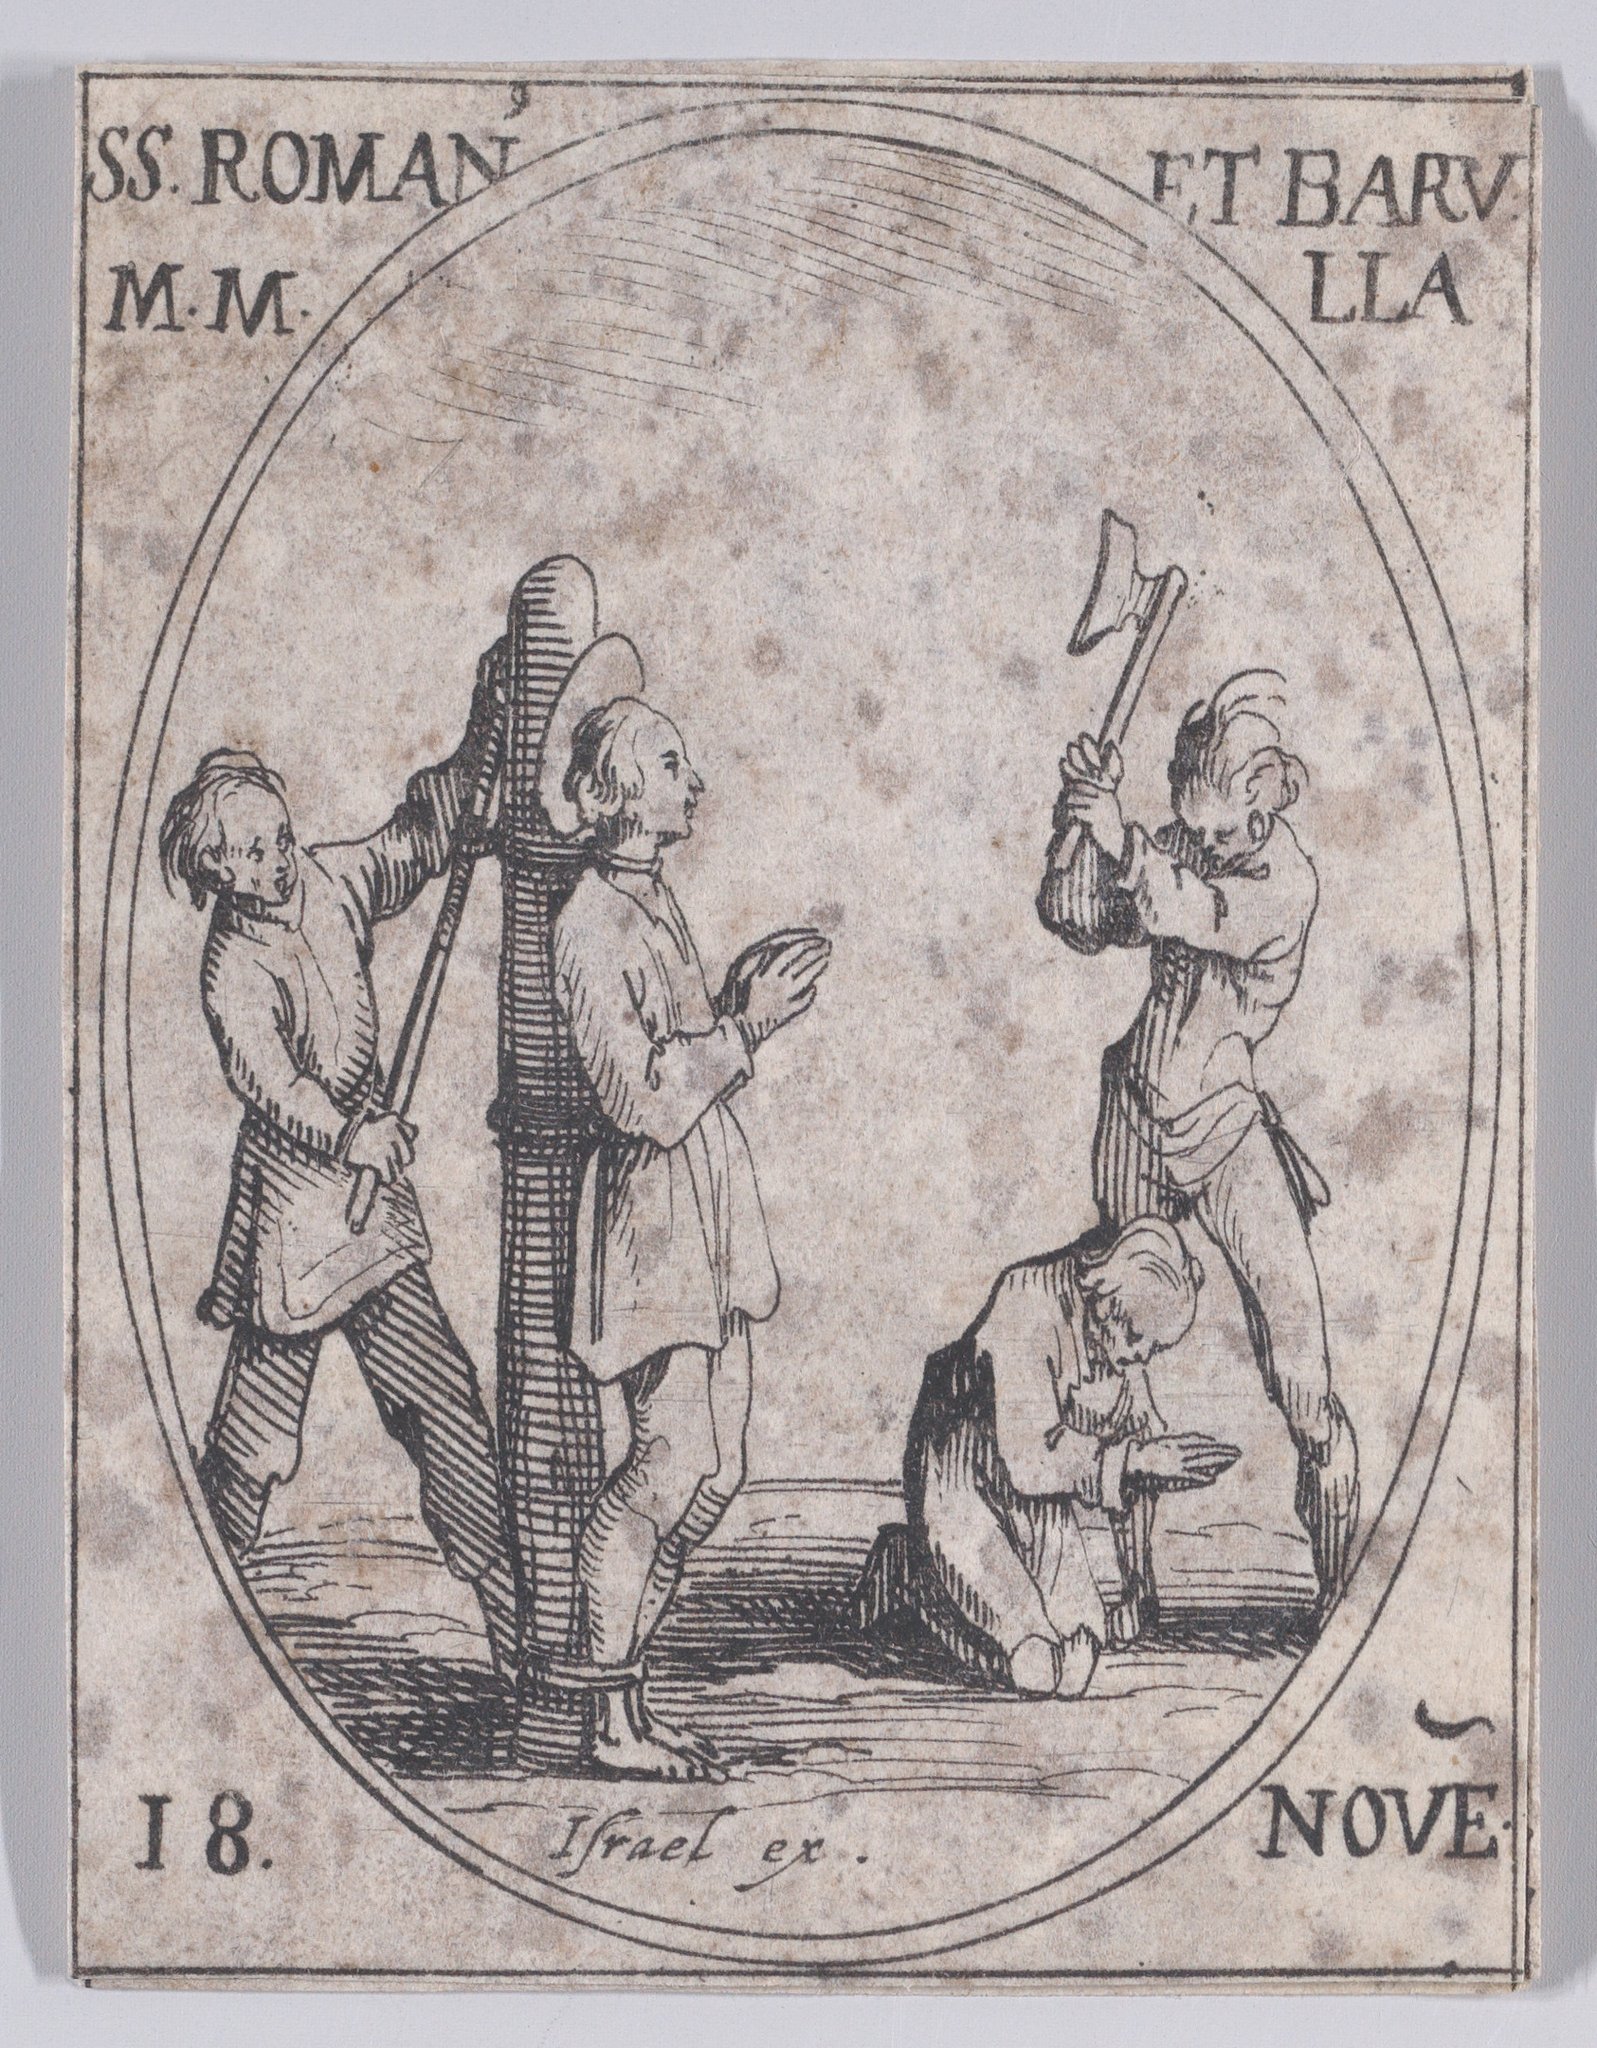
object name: print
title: S. Romain and S. Barulla (St. Romanus and St. Barula), November 18th, from "Les Images De Tous Les Saincts et Saintes de L'Année" (Images of All of the Saints and Religious Events of the Year)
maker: jacques callot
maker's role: artist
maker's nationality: french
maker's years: 1592-1635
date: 1636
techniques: etching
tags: men,saints